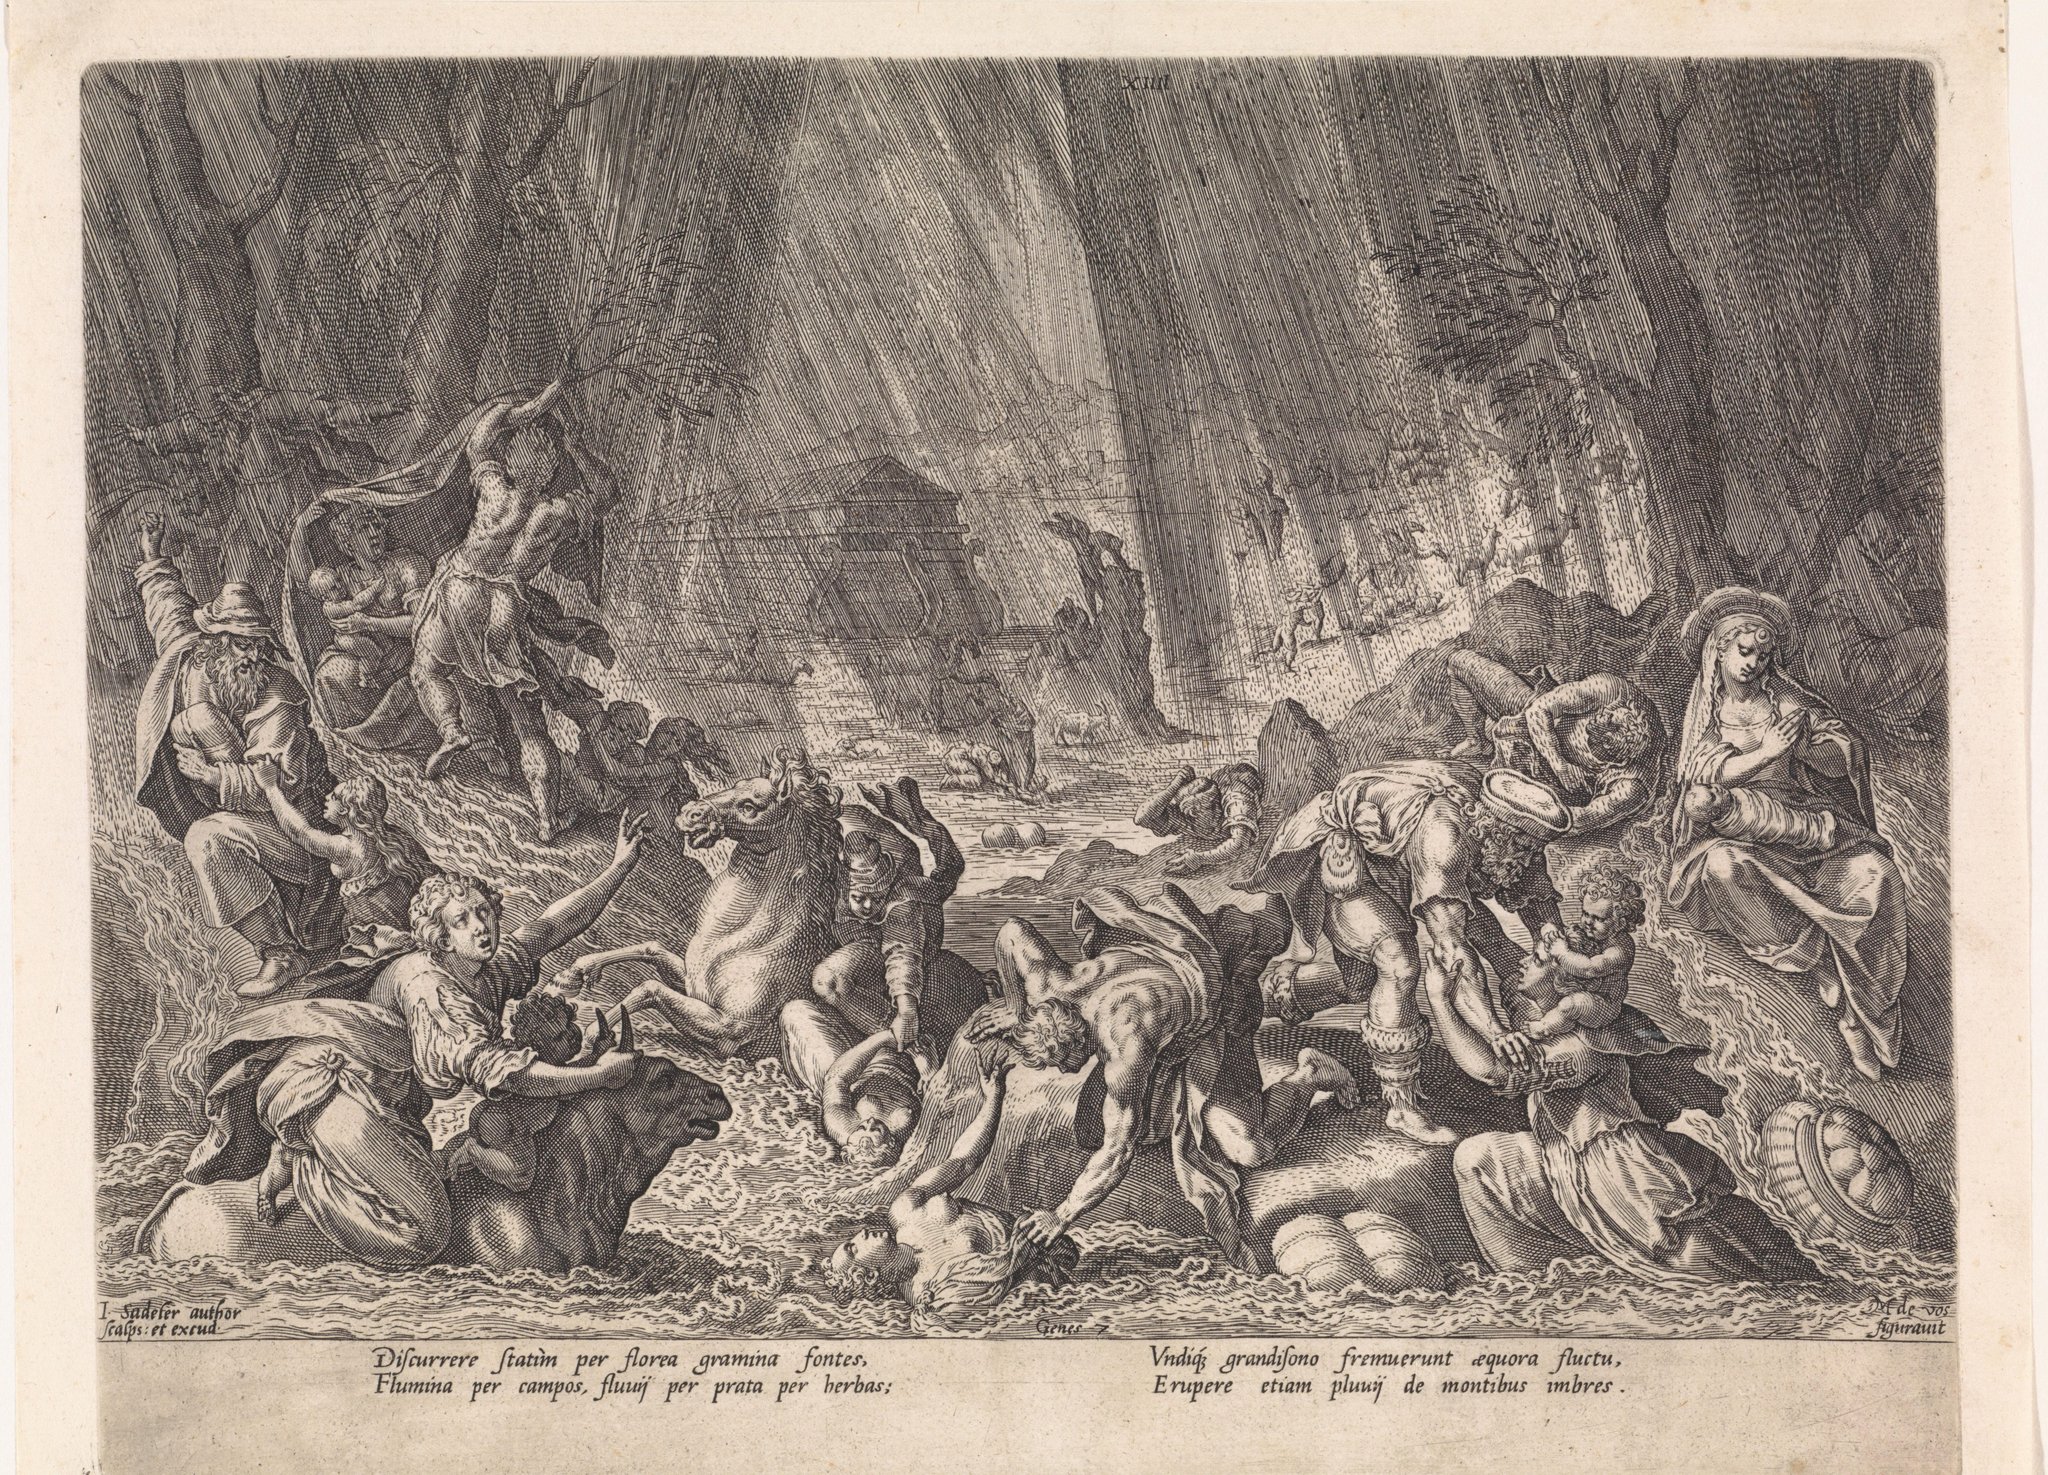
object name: print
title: Geschiedenis van de familie van Set / Over het goed en het slecht oordelen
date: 1586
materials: paper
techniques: engraving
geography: antwerp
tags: the ark is floating on the waters, while life on earth is destroyed ~ story of noah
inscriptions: collector's mark: Lugt 240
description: Het begin van de zondvloed. Het regent en op de voorgrond proberen mensen zich te redden door zich op hoger gelegen land te begeven. Anderen verdrinken. Op de achtergrond de ark van Noach. De prent heeft een Latijns onderschrift.